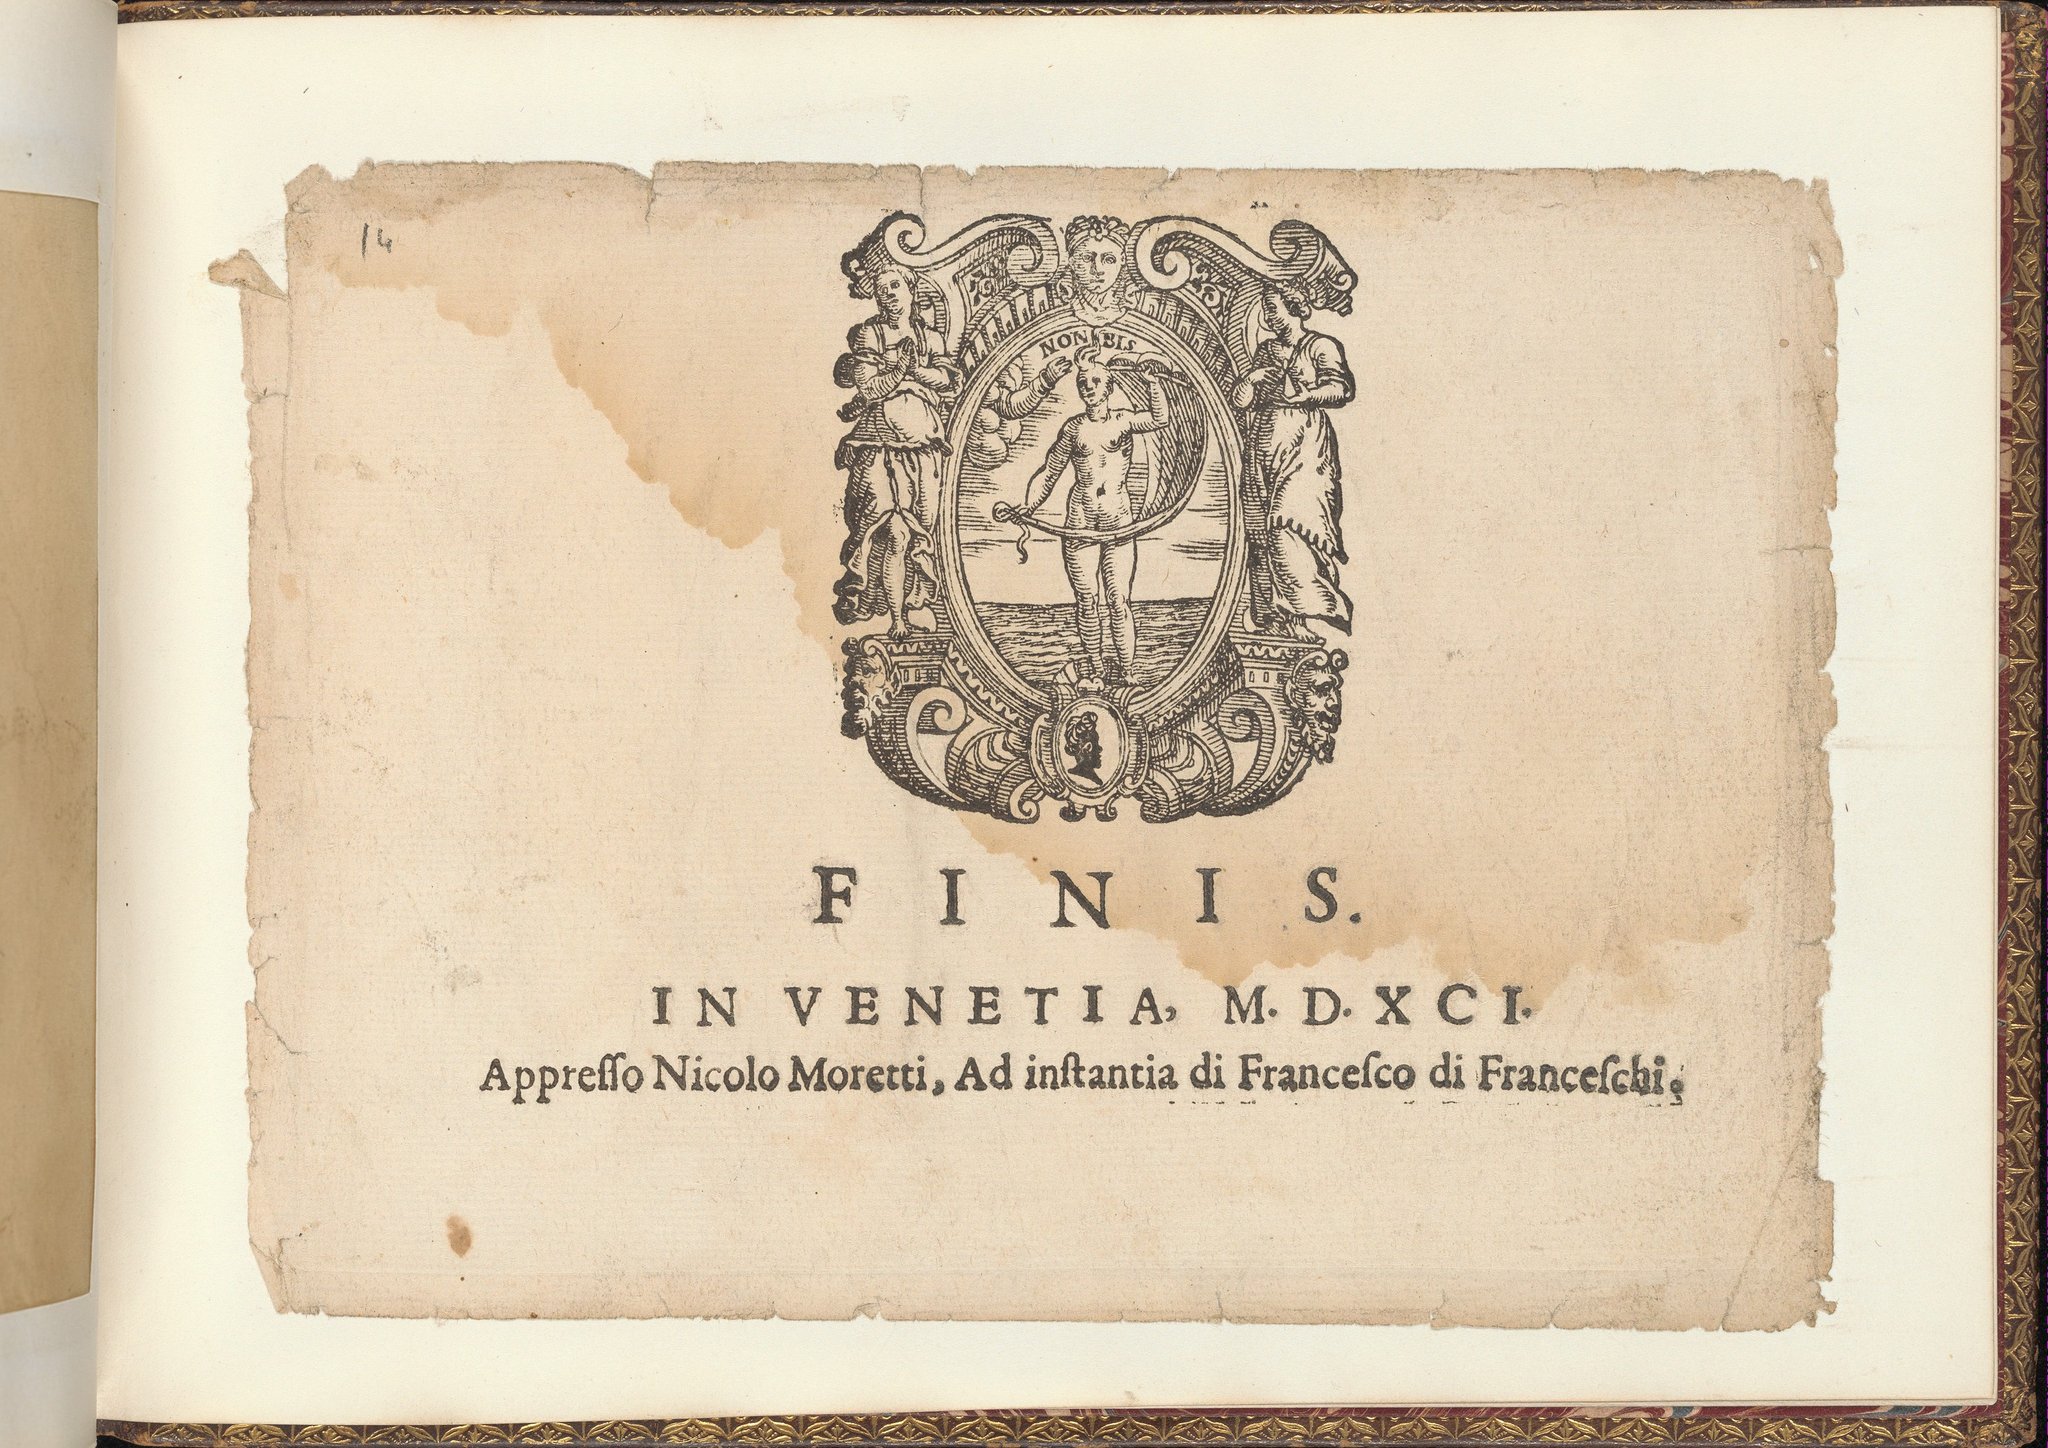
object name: book print ornament architecture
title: Prima parte de' fiori, page 15 (recto)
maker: giovanni battista ciotti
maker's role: author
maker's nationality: italian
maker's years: 1555-1659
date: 1591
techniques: woodcut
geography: italy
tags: female nudes